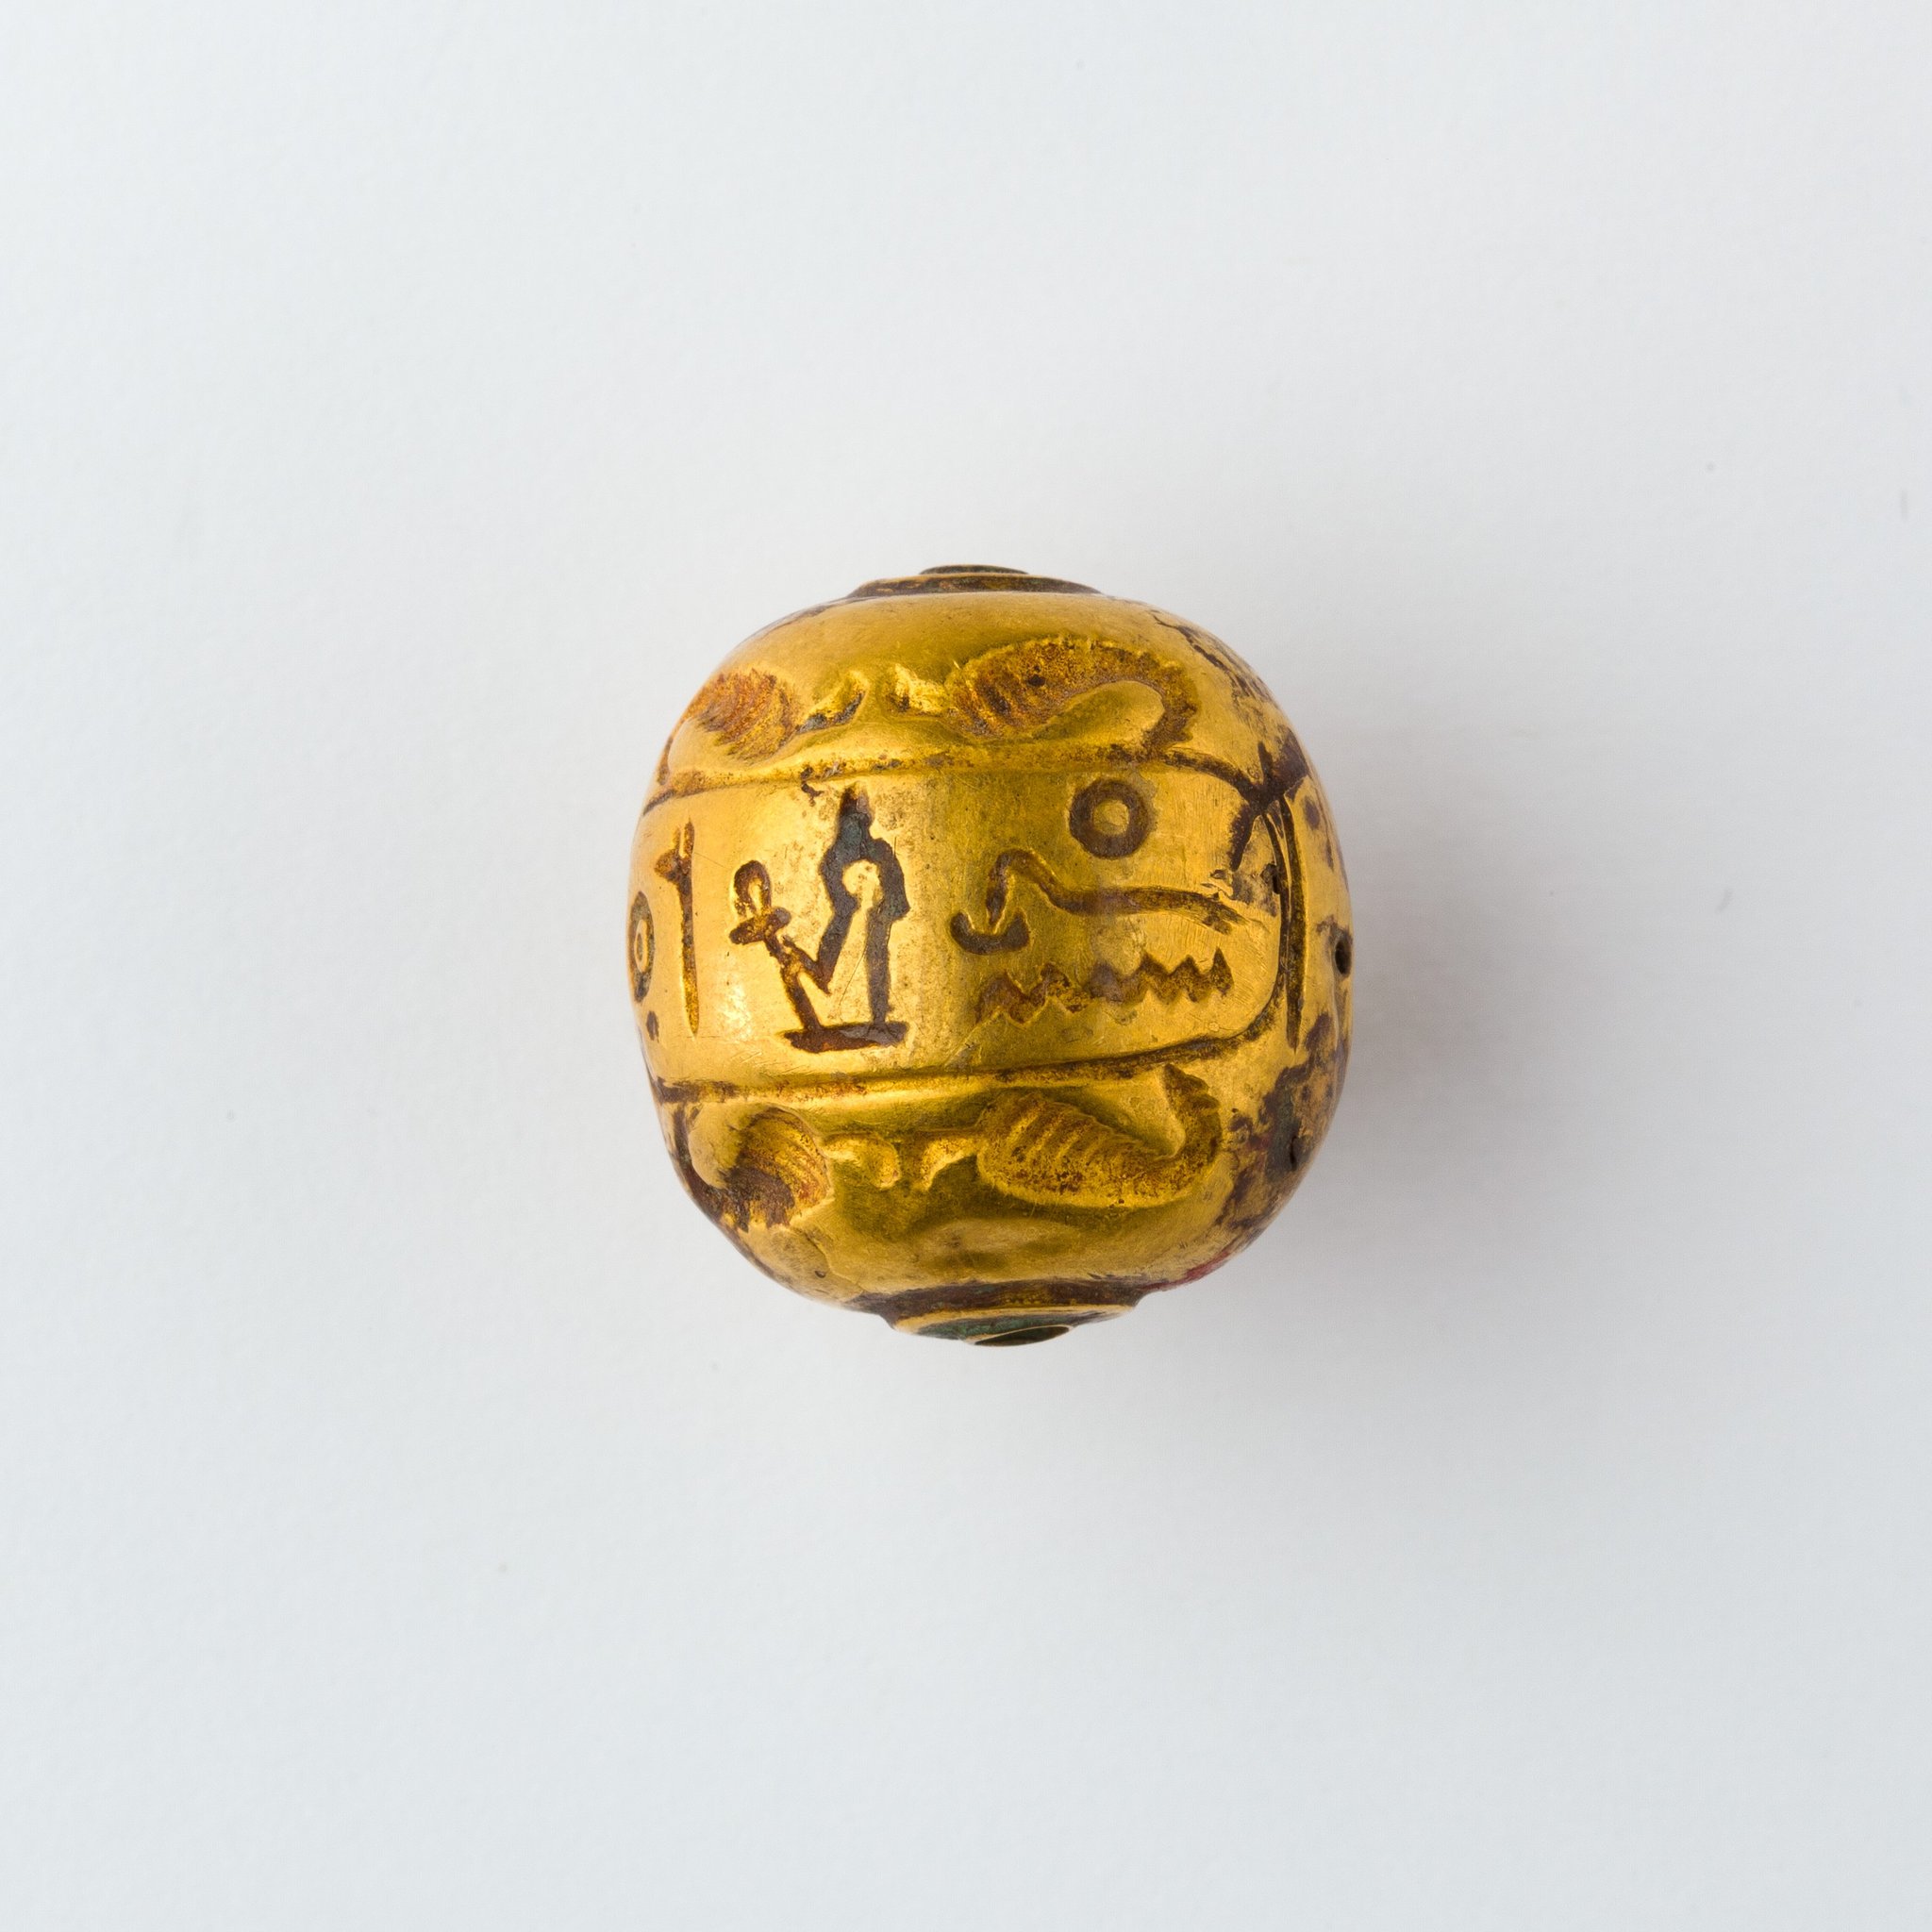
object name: bead, ramesses ii, isetnefret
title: Hollow spherical bead with the Names of Ramesses II and Queen Isetnefret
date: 1279-1213 BCE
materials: gold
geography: egypt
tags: hieroglyphs